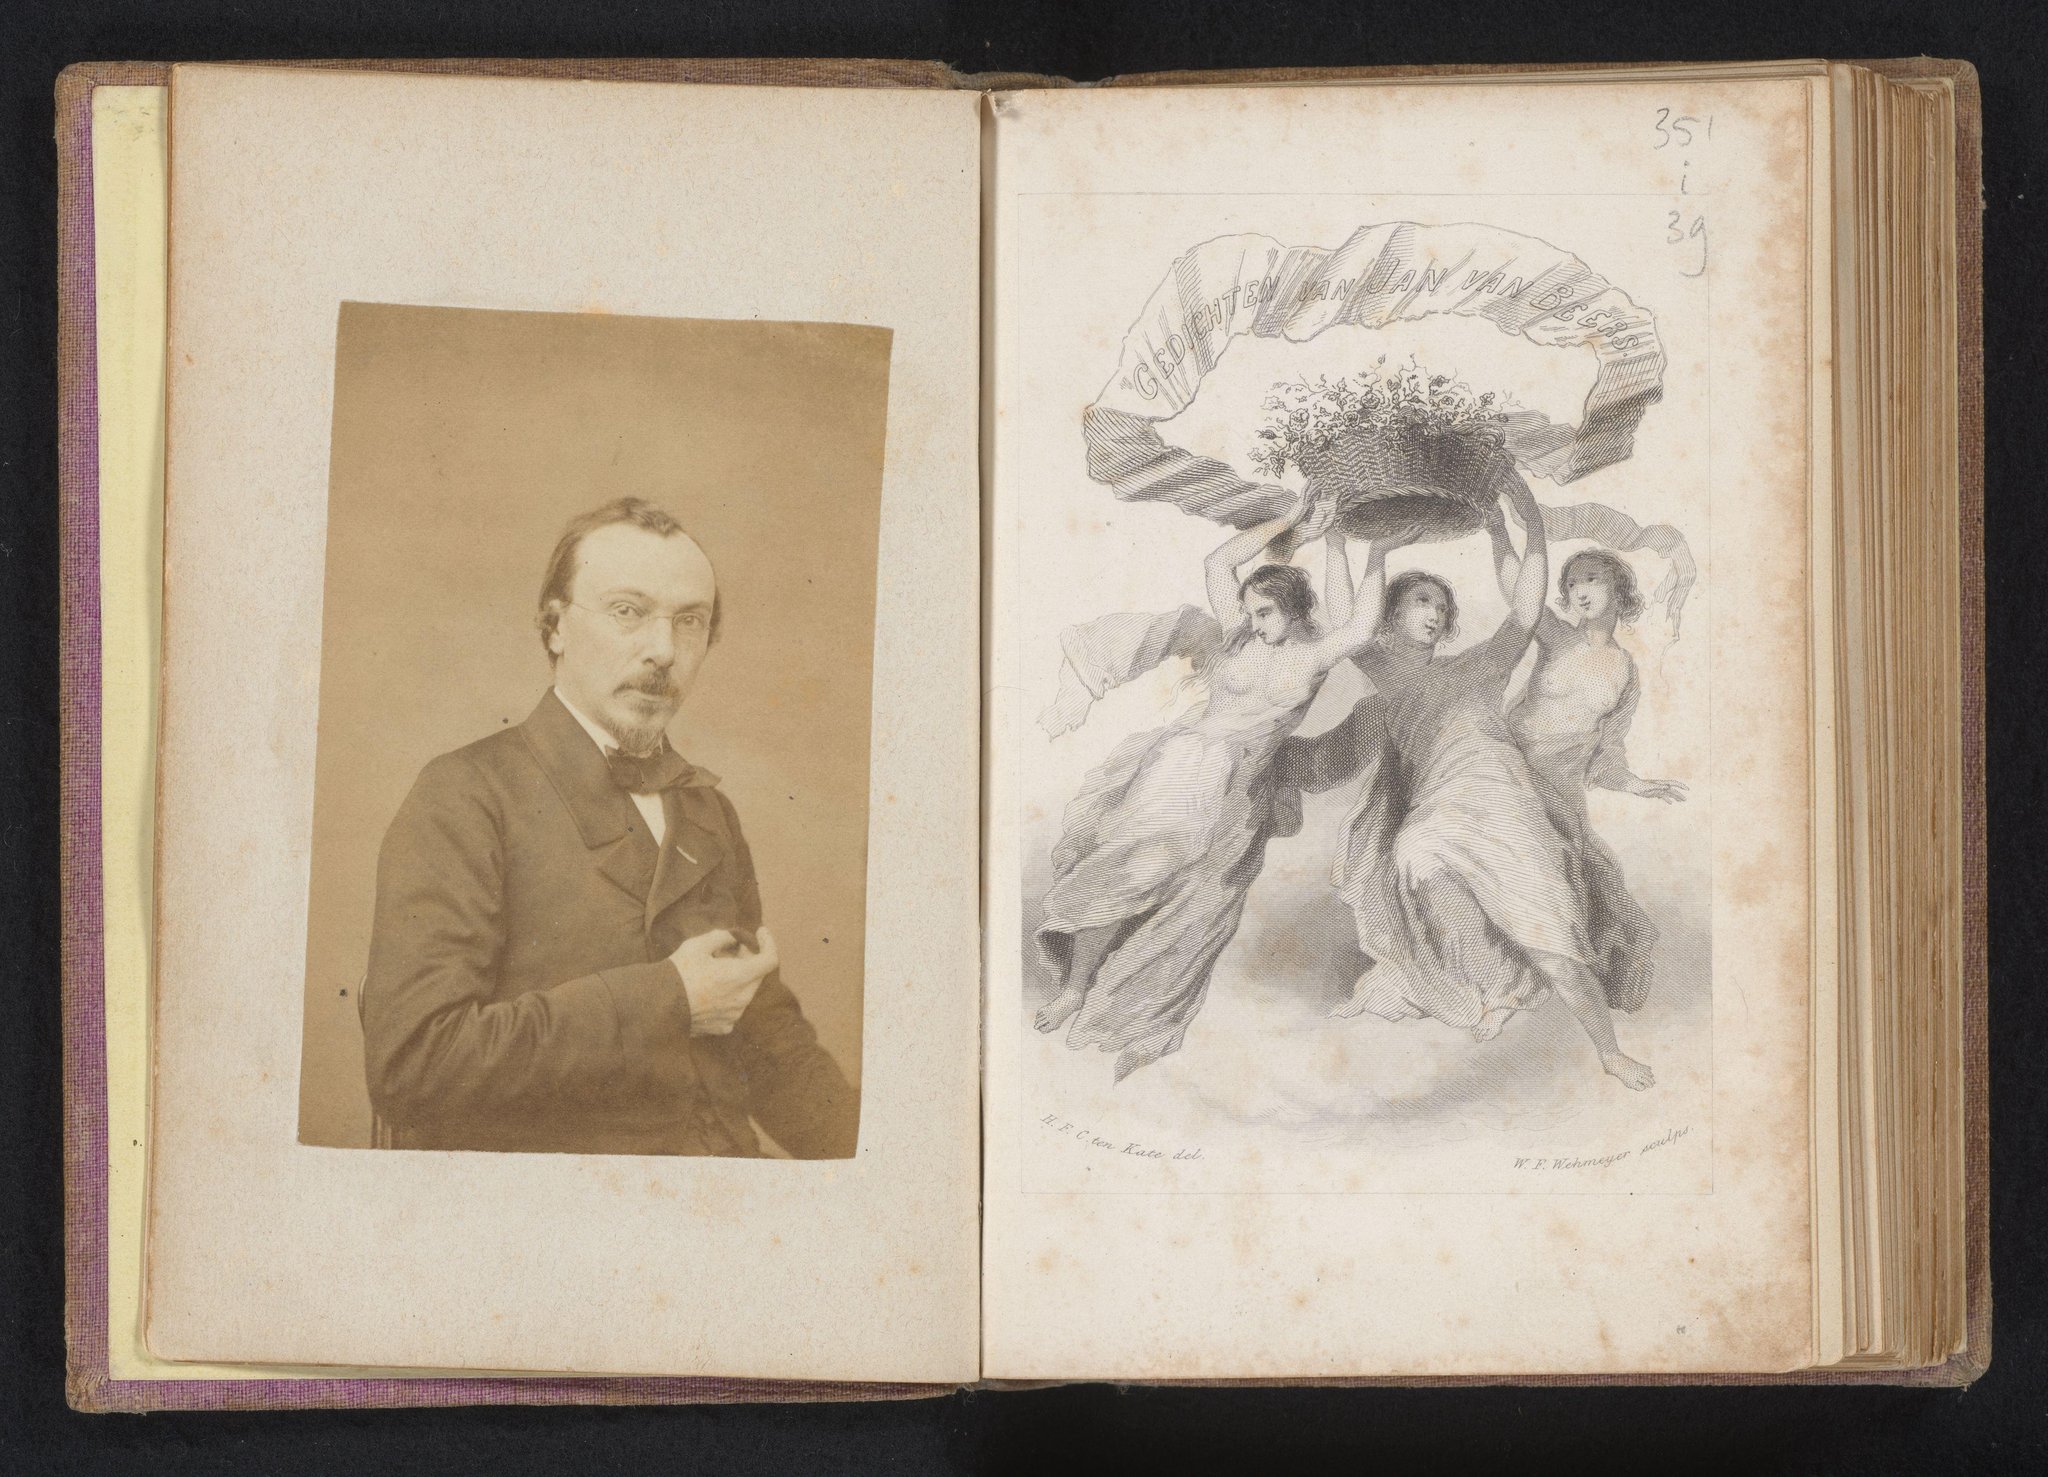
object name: book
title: Gedichten van Jan van Beers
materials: cardboard, paper, textile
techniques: albumen print, engraving, etching, letterpress printing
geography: the hague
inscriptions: inscription: ‘38,-/ met front. portret fotografie’